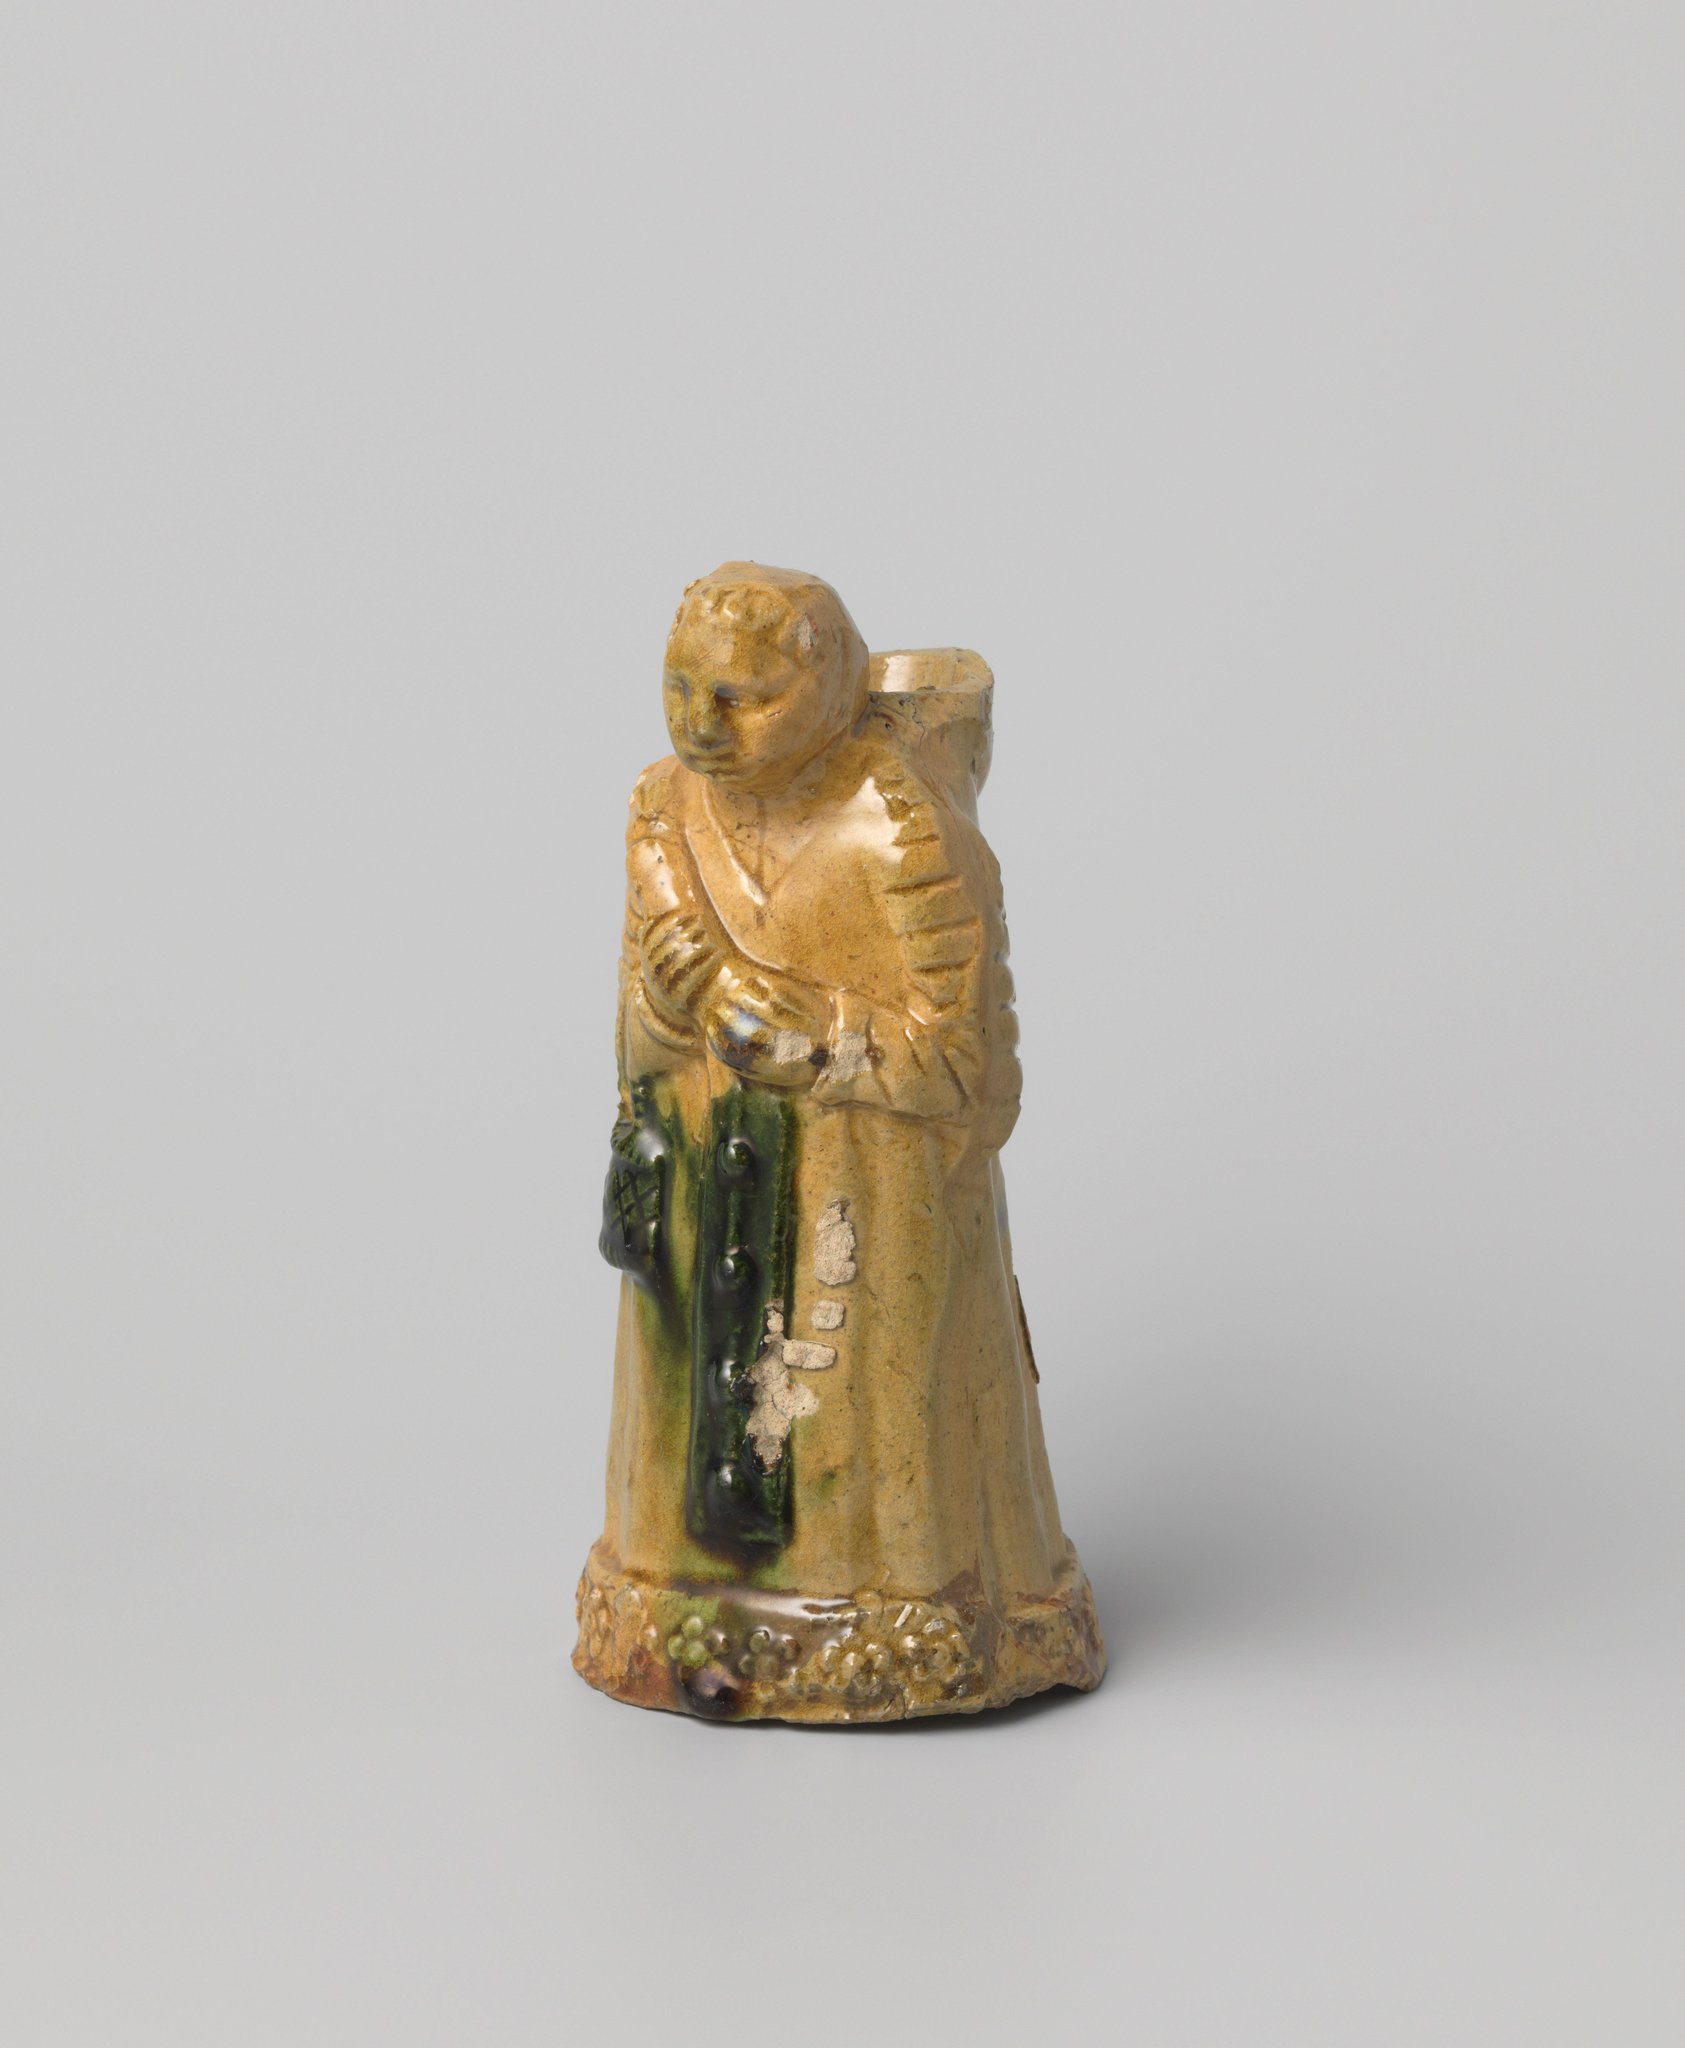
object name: cup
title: Monnikbeker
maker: Anonymous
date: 1600-1610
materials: earthenware, glaze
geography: netherlands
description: Beker van loodglazuuraardewerk, in de vorm van een monnik. De beker is bedekt met groene en gele loodglazuur. De capuchon op de rug vormt de beker. Aan de rechterarm hangt een groen tasje. Langs de onderrand van het kleed zijn rozetten aangebracht.